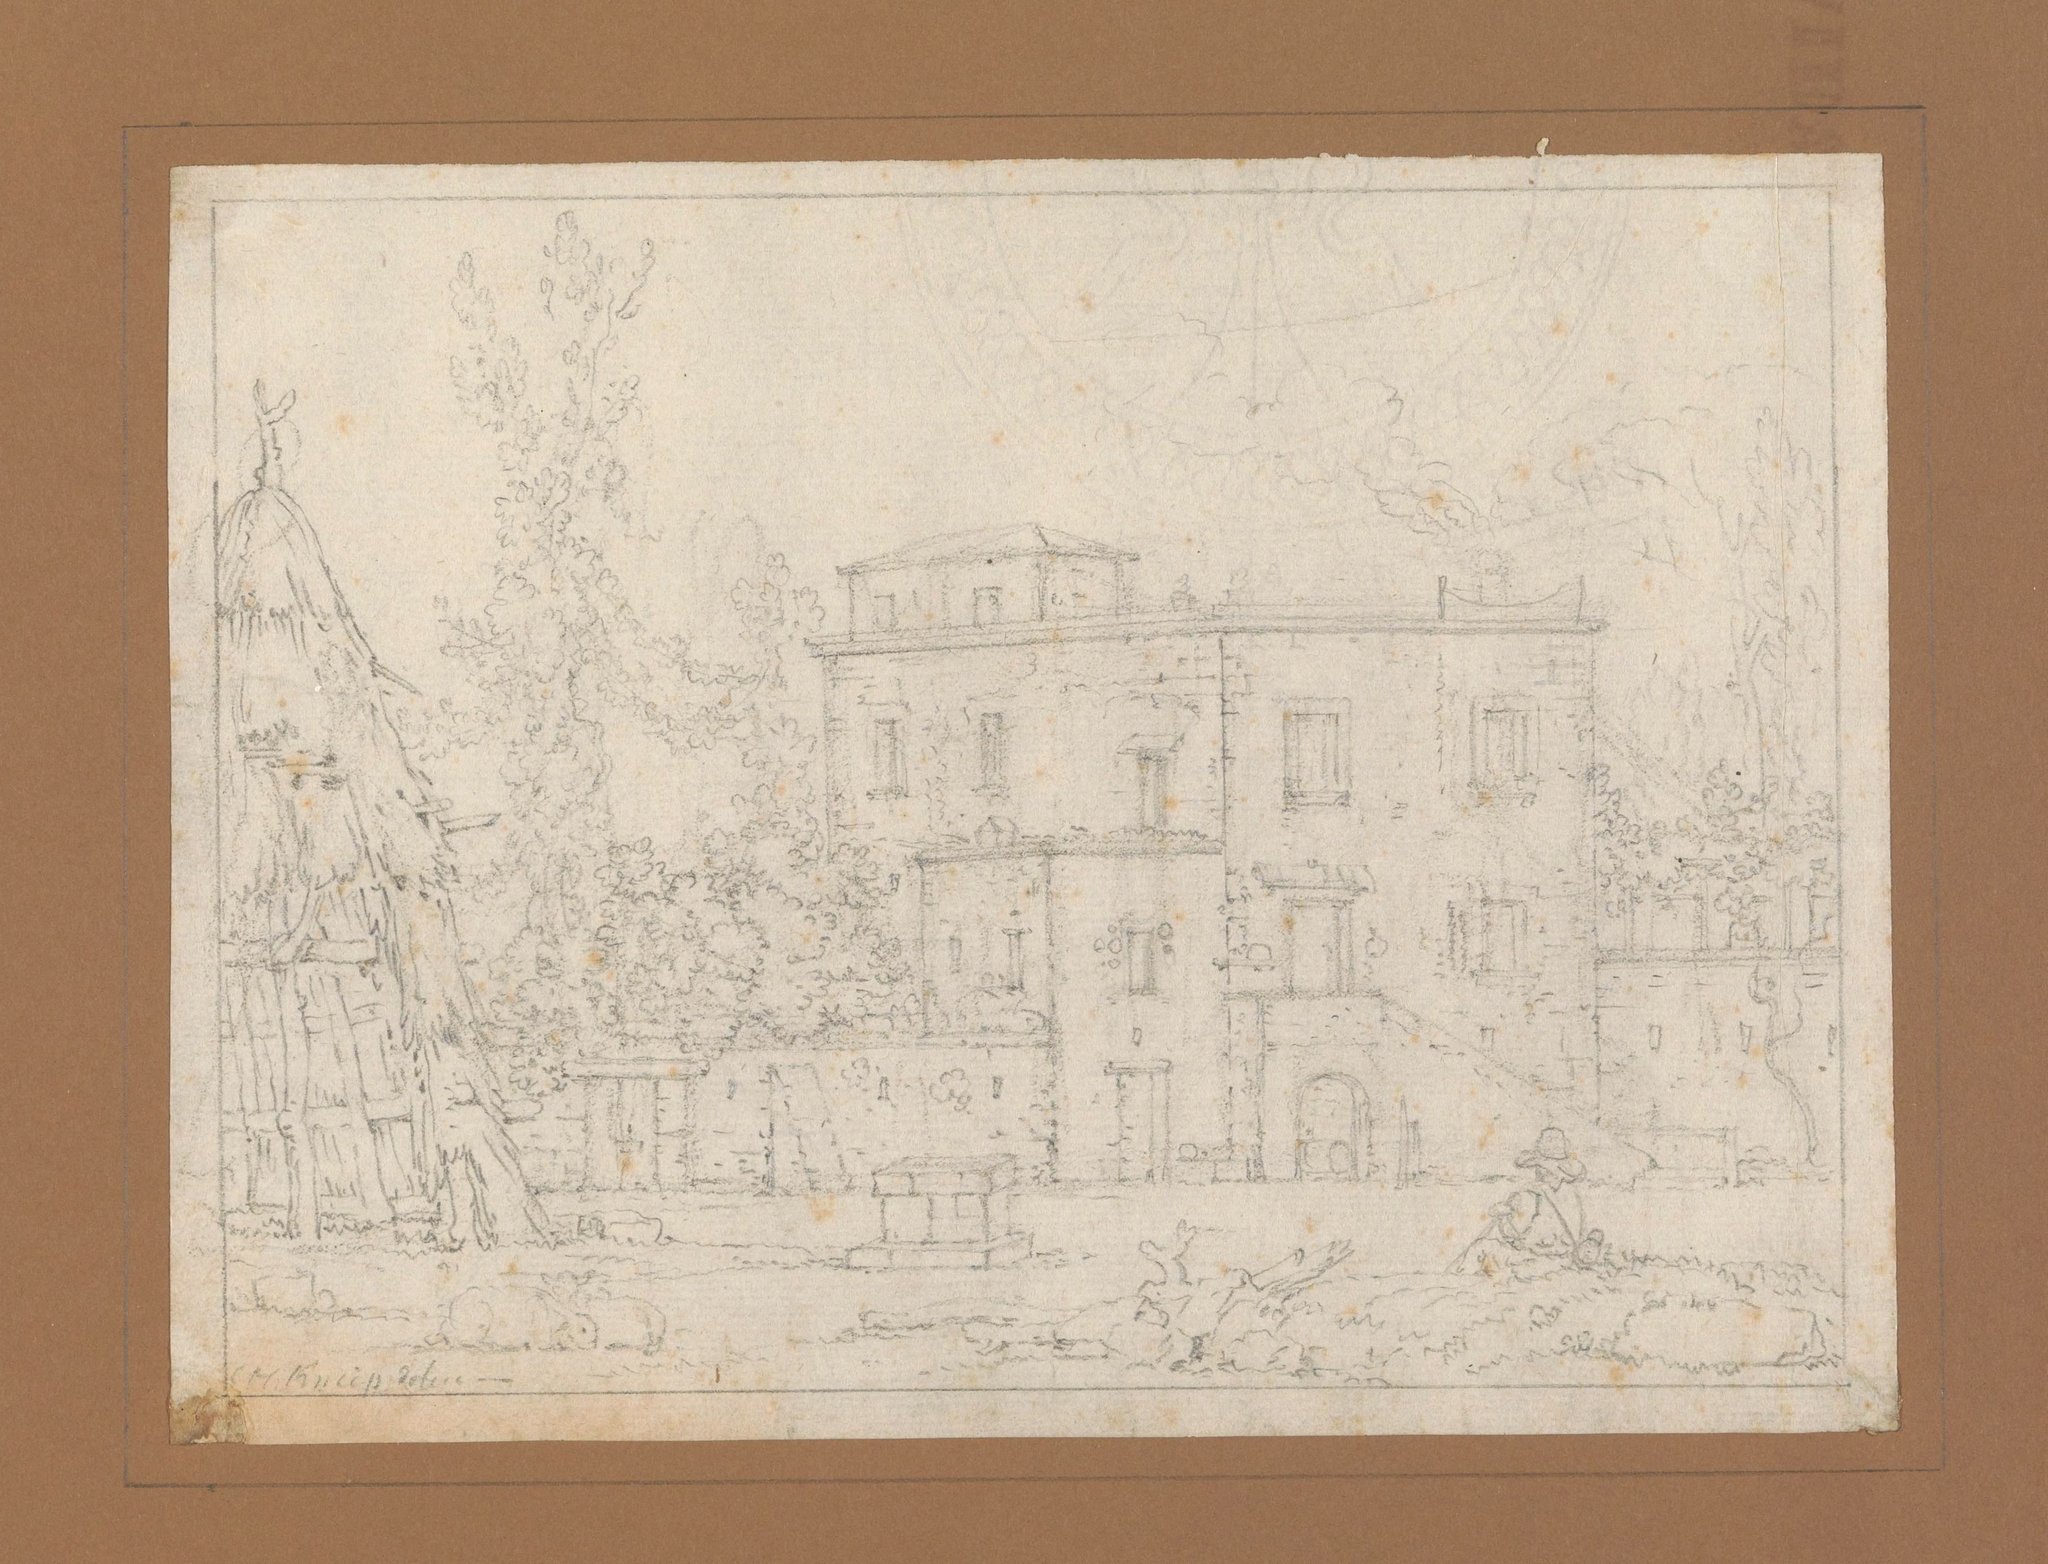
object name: drawing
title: Villa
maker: christoph heinrich kniep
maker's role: draughtsman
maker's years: 1755-1825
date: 1765-1825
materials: paper, pencil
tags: villa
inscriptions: collector's mark: Lugt 2228